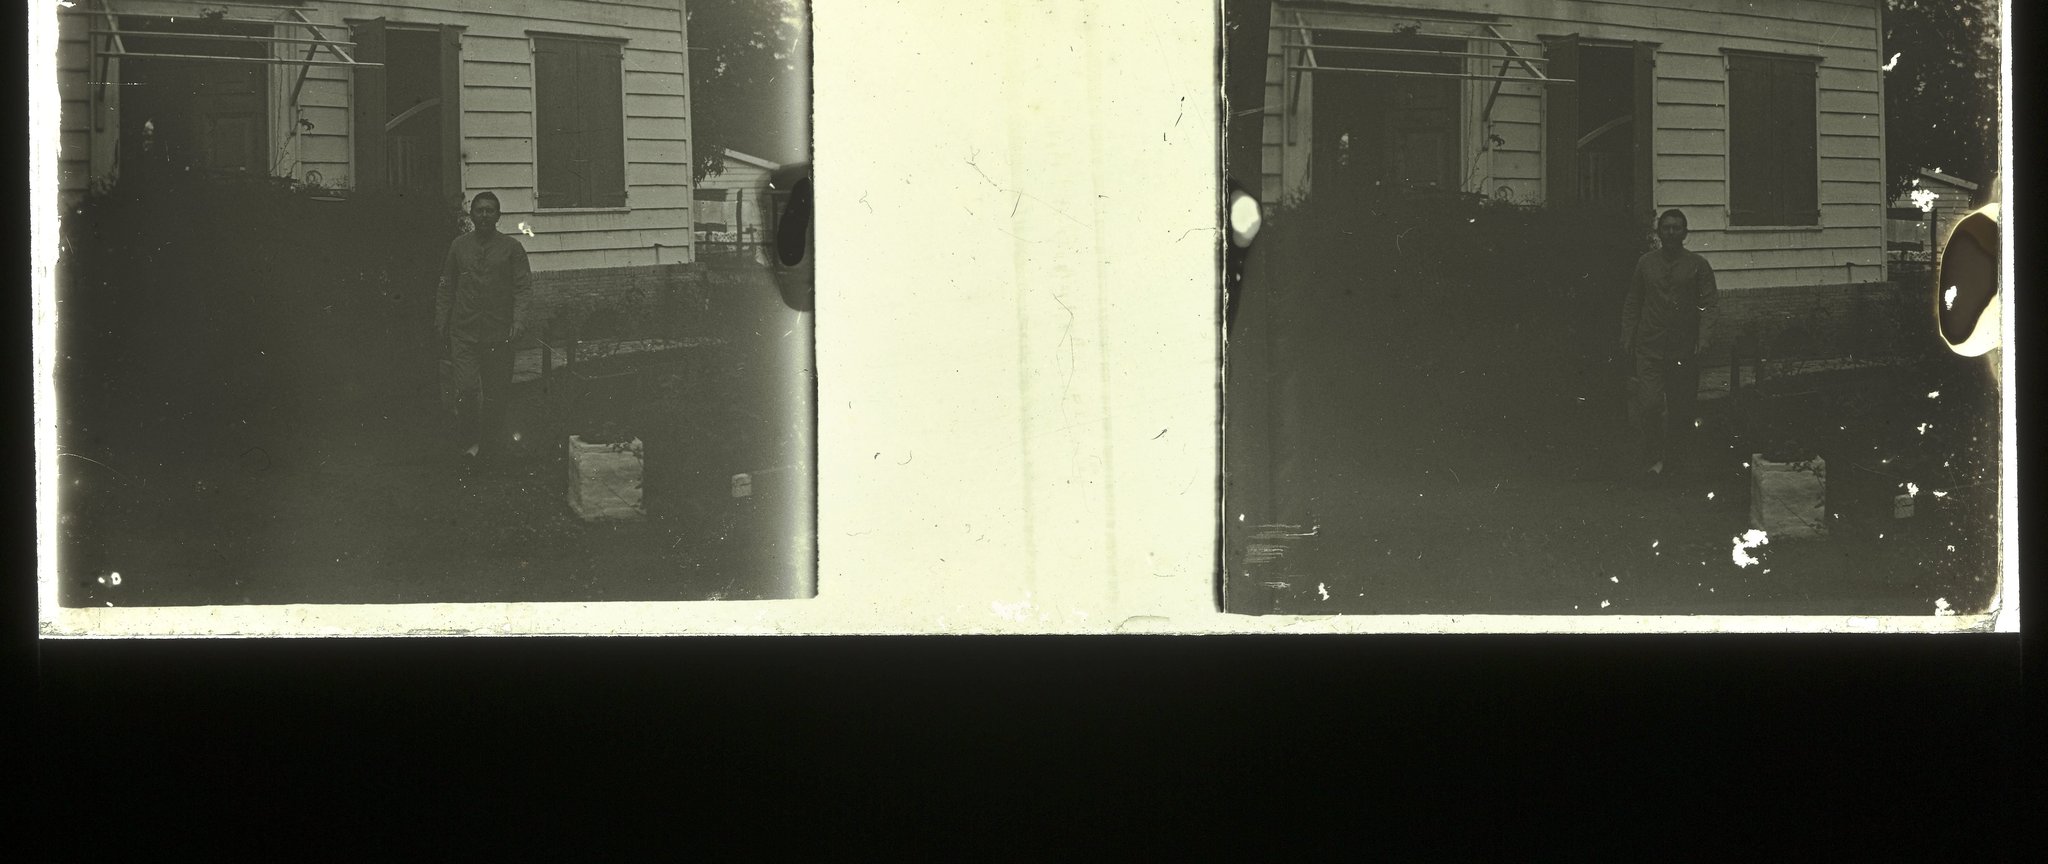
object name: stereograph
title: Theodoor Brouwers op plantage Accaribo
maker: Anonymous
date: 1913-1930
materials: glass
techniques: photography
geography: suriname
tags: theodoor brouwers, plantation, suriname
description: In de periode 1911-1932 woonde op plantage Accaribo in Suriname de familie Brouwers van wie de foto's afkomstig zijn. Rond 1910 vond Theodoor Brouwers werk op plantage Accaribo. In 1929 werd hij eigenaar van de plantage. Op Accaribo werden in zijn tijd bananen geproduceerd en wat koffie.